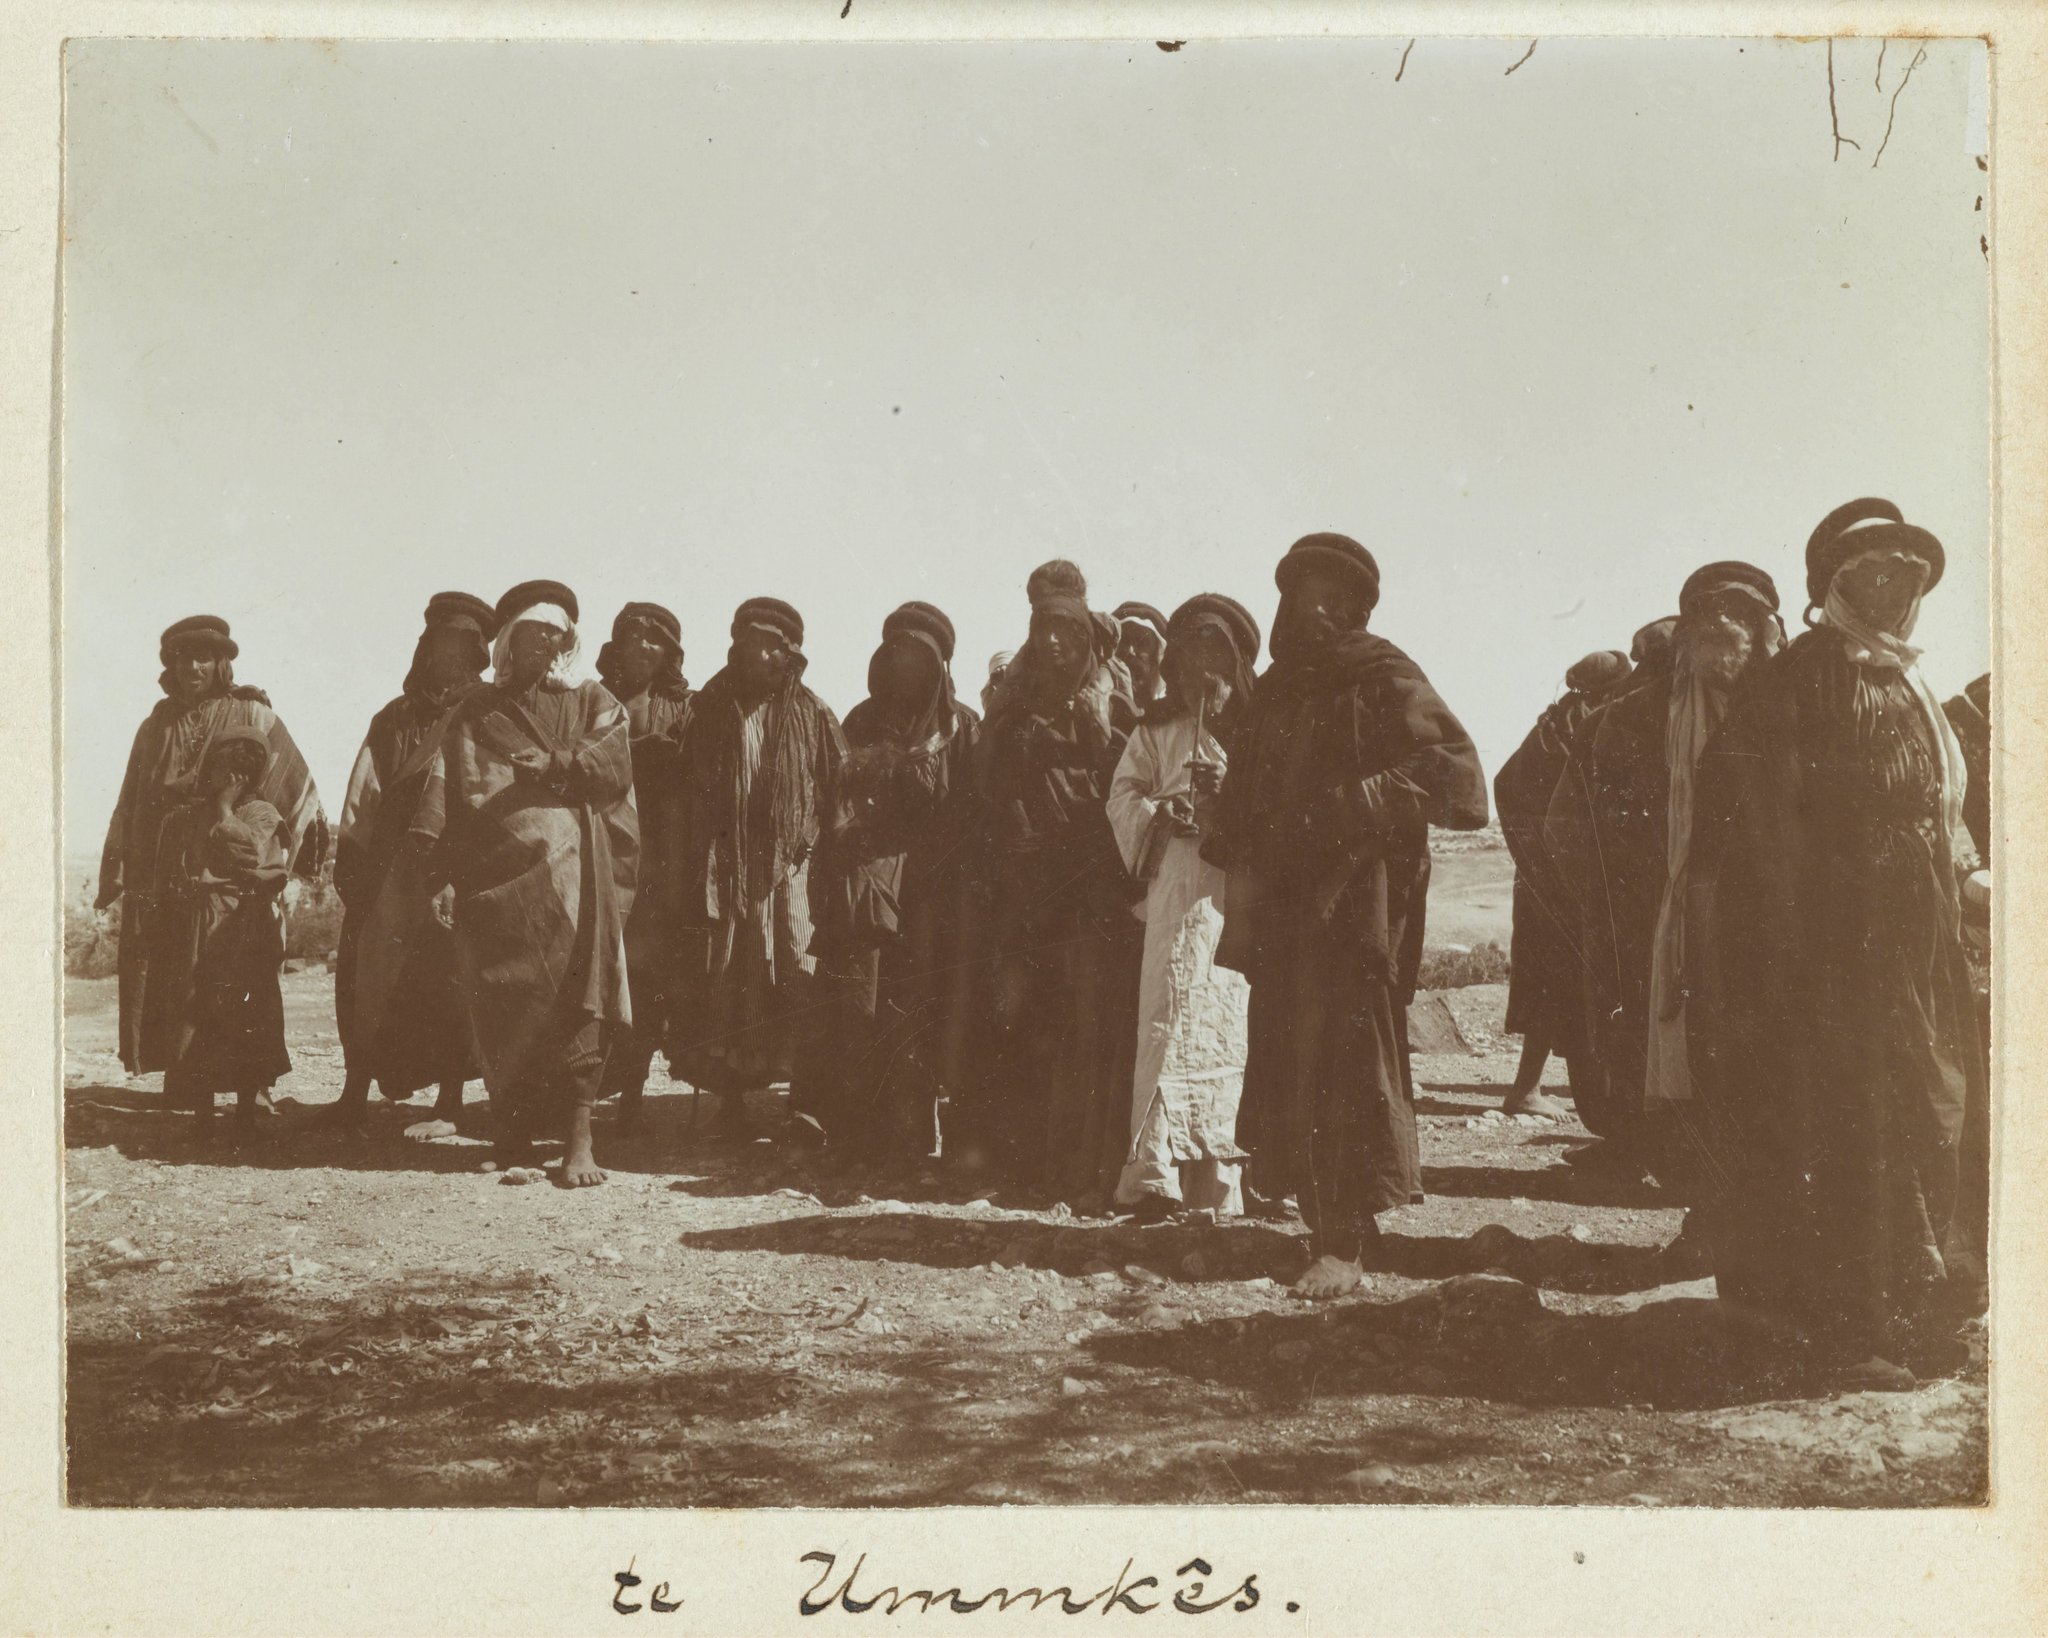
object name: photograph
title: Verschillende landelijke en huiselijke tafereelen te Ummkês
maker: johannes lodewijk heldring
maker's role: fotograaf, predikant, schrijver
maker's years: 1852-1923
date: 1898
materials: paper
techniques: collodion silver print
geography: jordan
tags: anonymous historical persons portrayed in a group, in a group-portrait